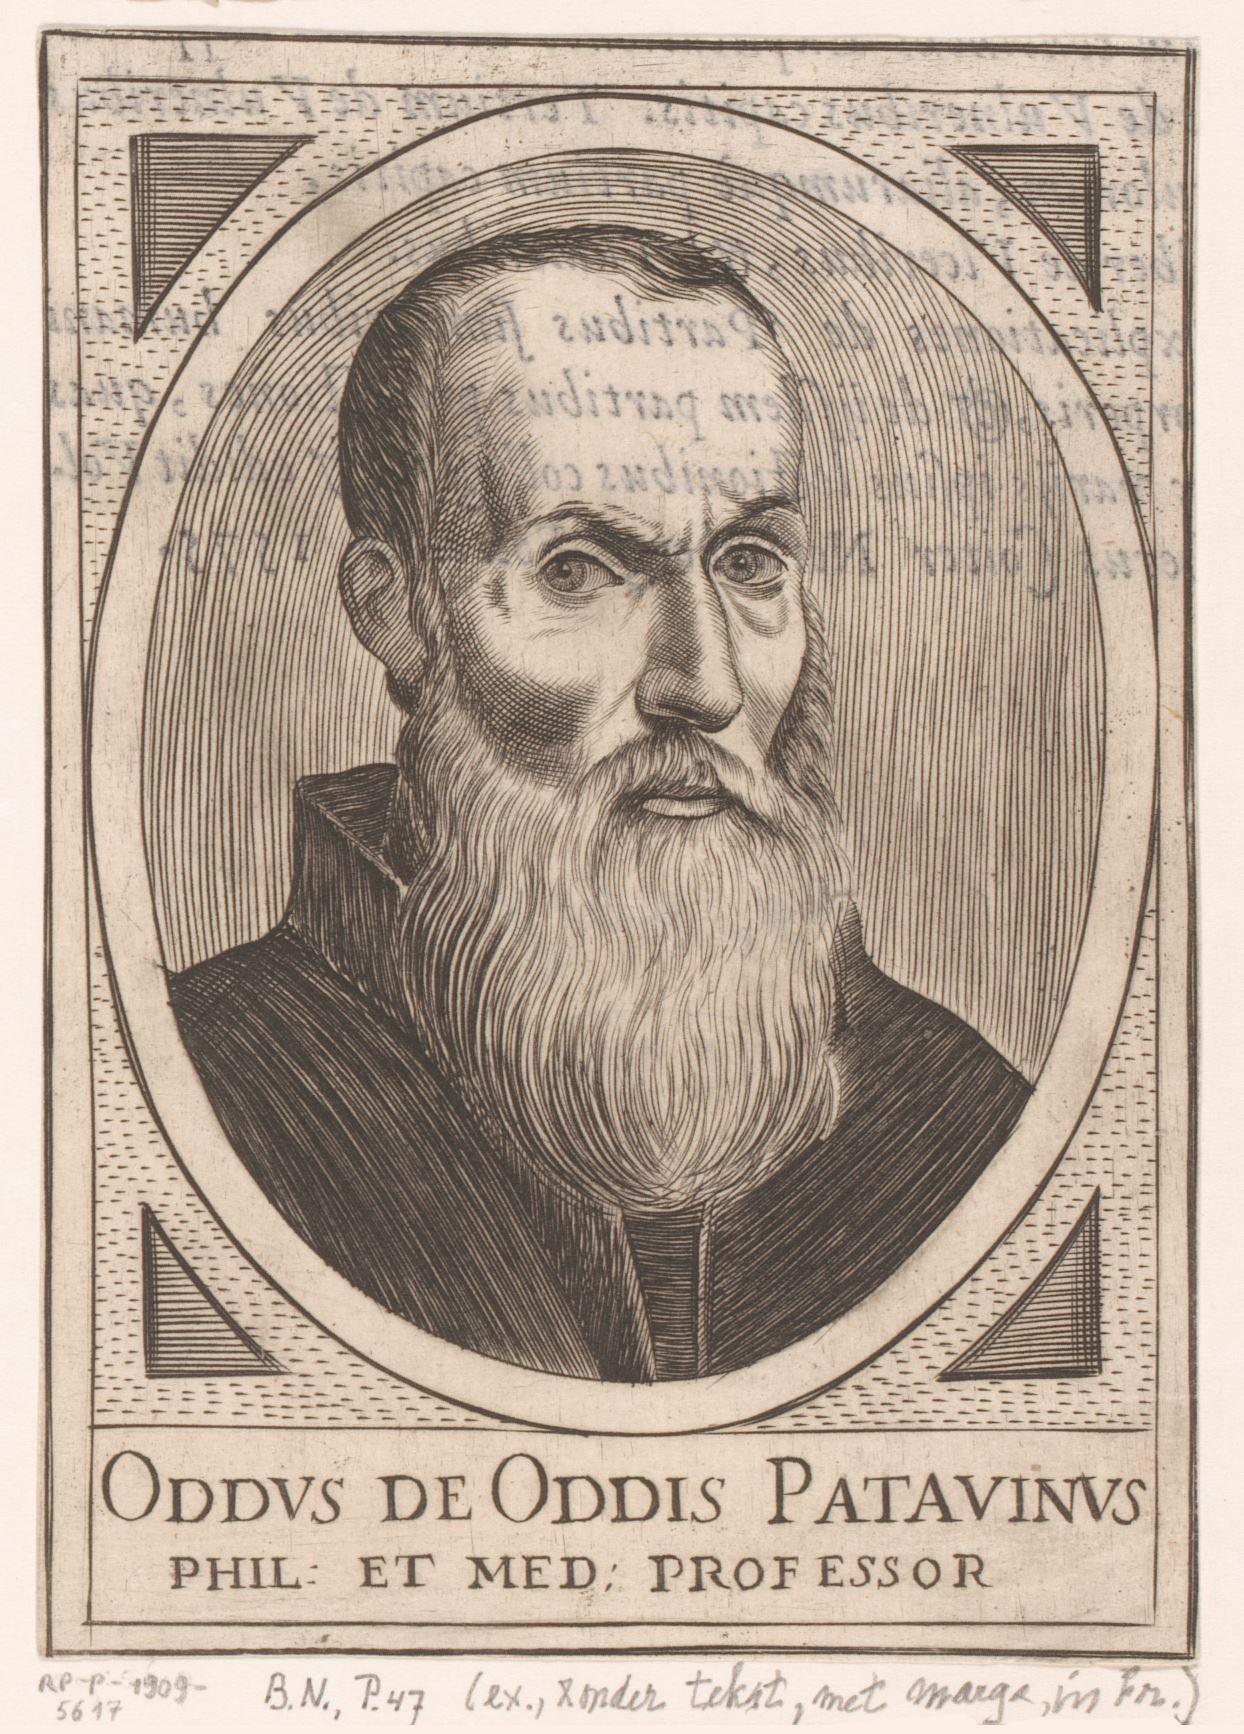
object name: book illustration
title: Portret van Oddo degli Oddi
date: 1630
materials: paper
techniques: engraving, letterpress printing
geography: padua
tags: ornament ~ medallion, historical persons, physician, doctor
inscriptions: collector's mark: Lugt 2228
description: Prent uit: Tomasini, Jacopo Filippo. Jacobi Philippi Tomasini Patavini Illustrium Virorum Elogia Iconibus Exornata (...). Padua: Donato Pasquardi, 1630, p. 47.